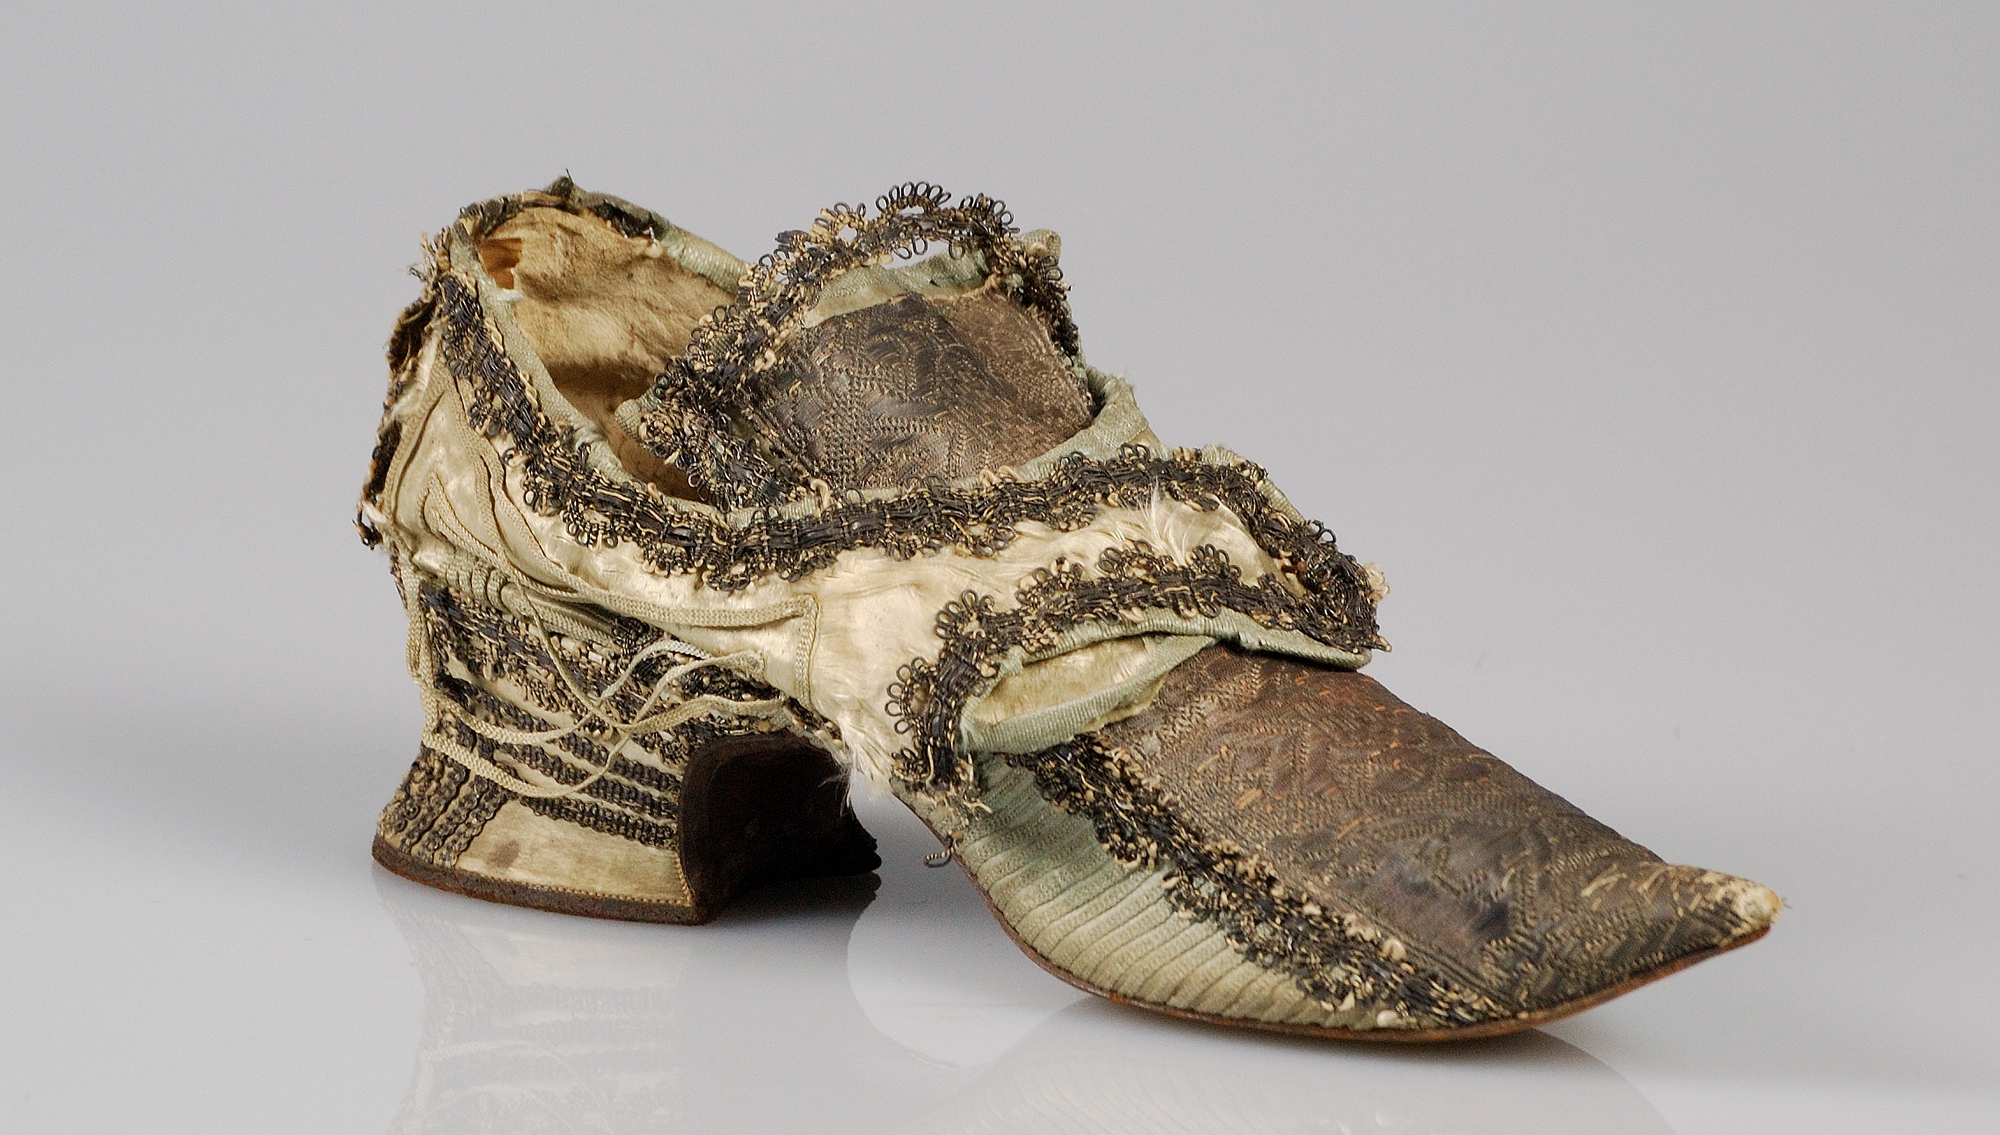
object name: shoe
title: Shoes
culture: british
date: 1720-1740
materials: silk